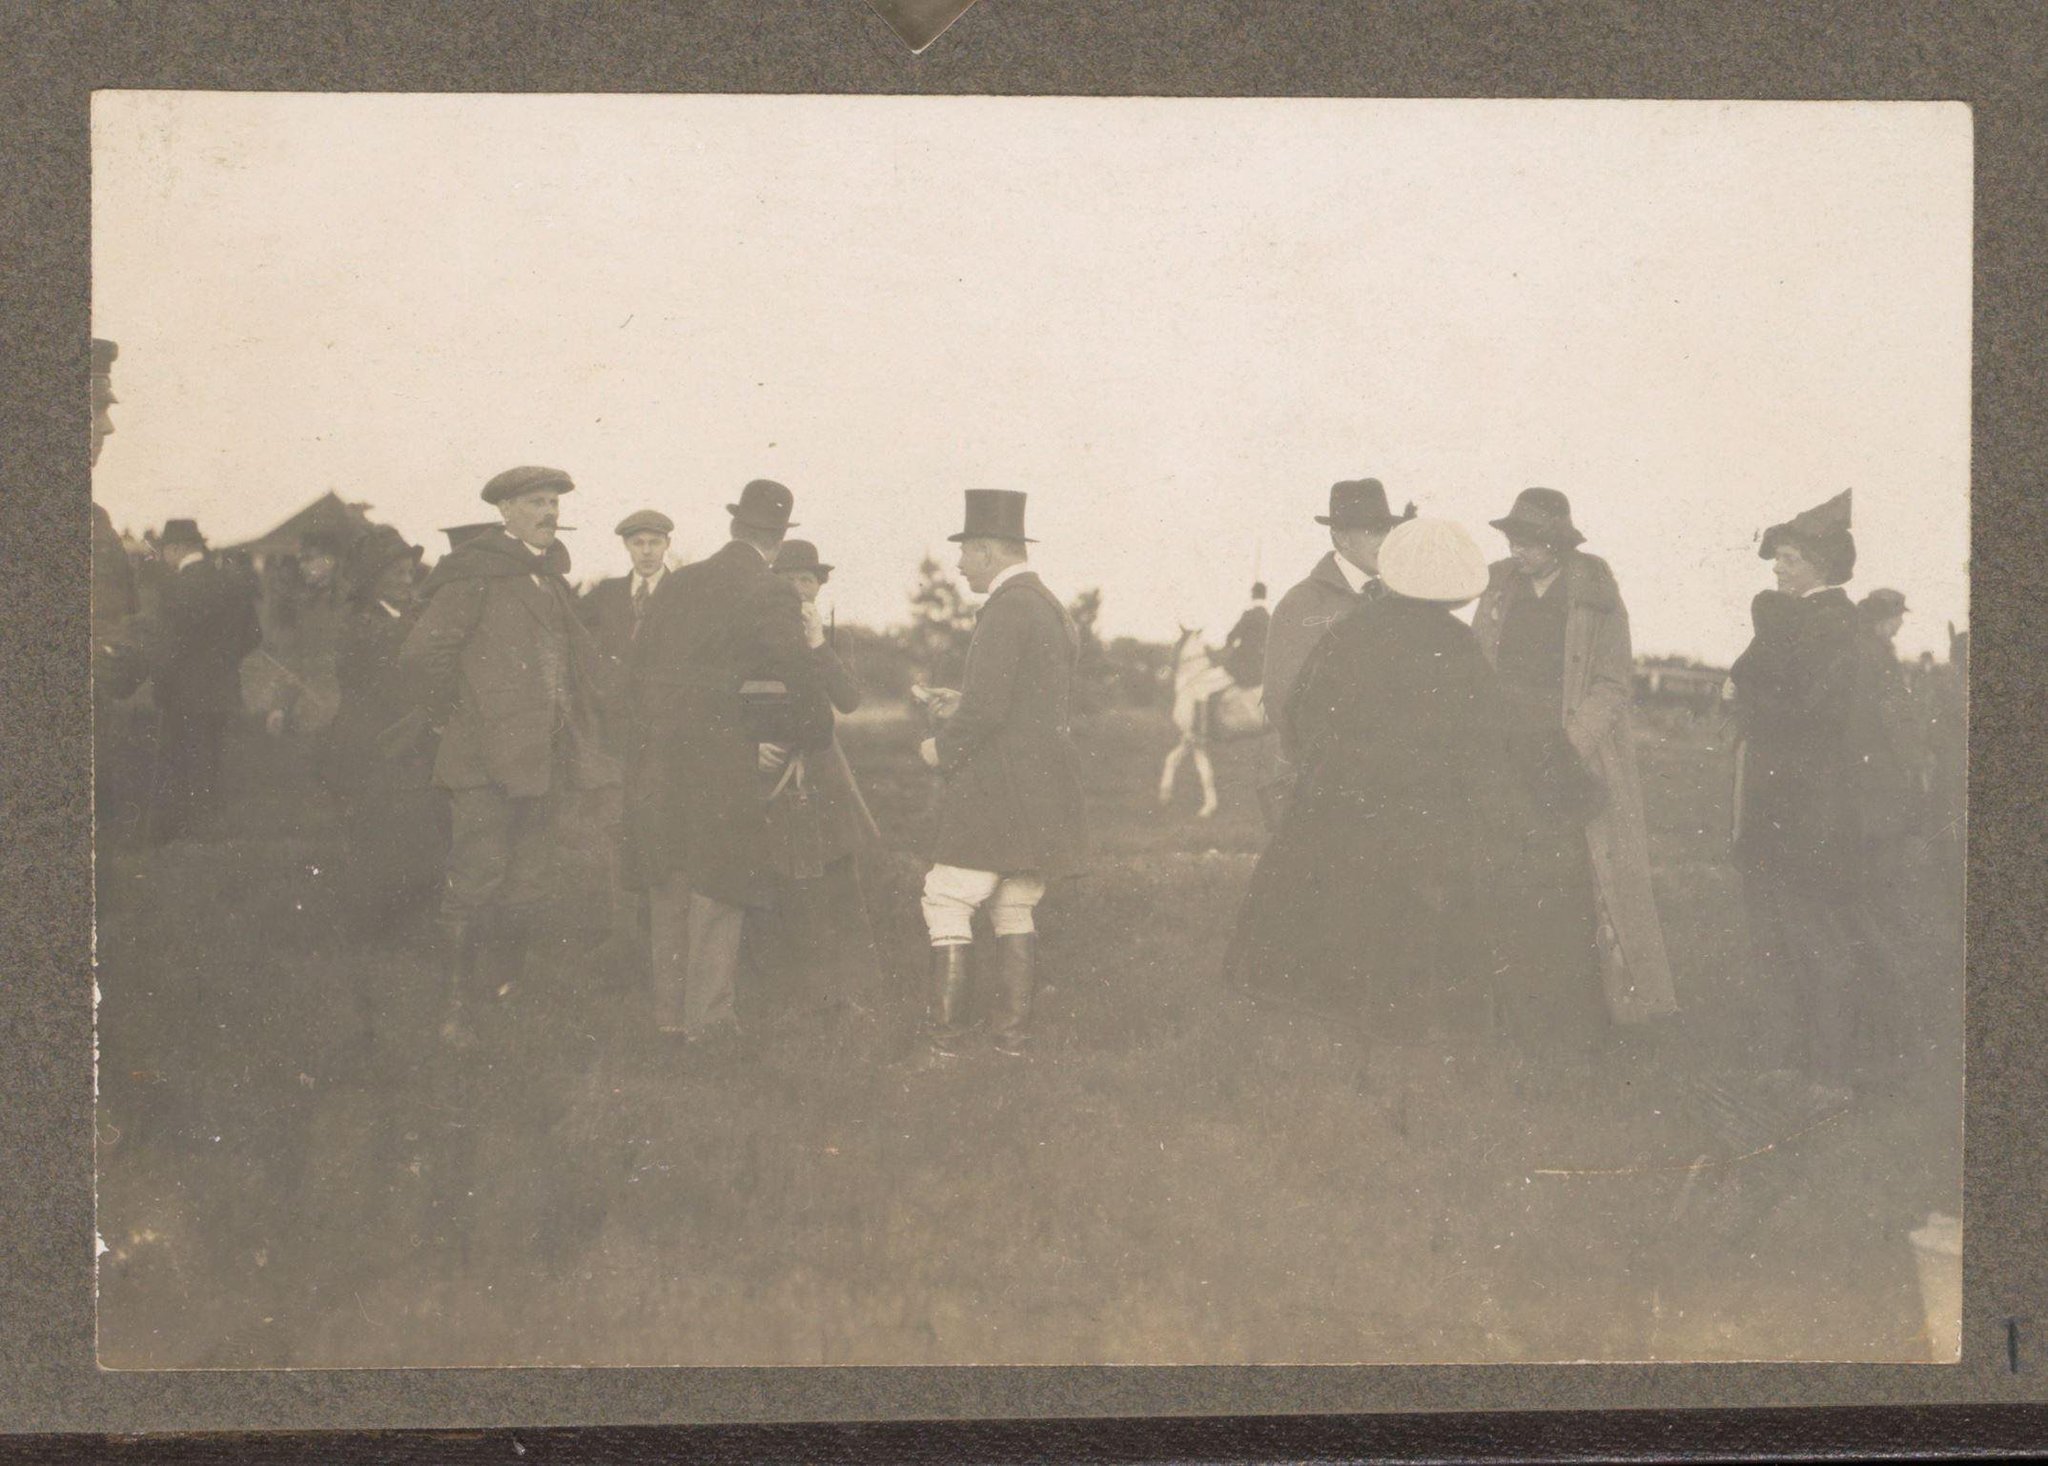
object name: photograph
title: Ruitertafereel op Koninklijke Houtvesterij Het Loo: publiek op de hei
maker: Anonymous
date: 1900-1925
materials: photographic support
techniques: gelatin silver print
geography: het loo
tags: hunting, chase, hunting-ground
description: Onderdeel van Fotoalbum van de heer Brams, opperhoutvester van koningin Wilhelmina op Koninklijke Houtvesterij Het Loo.